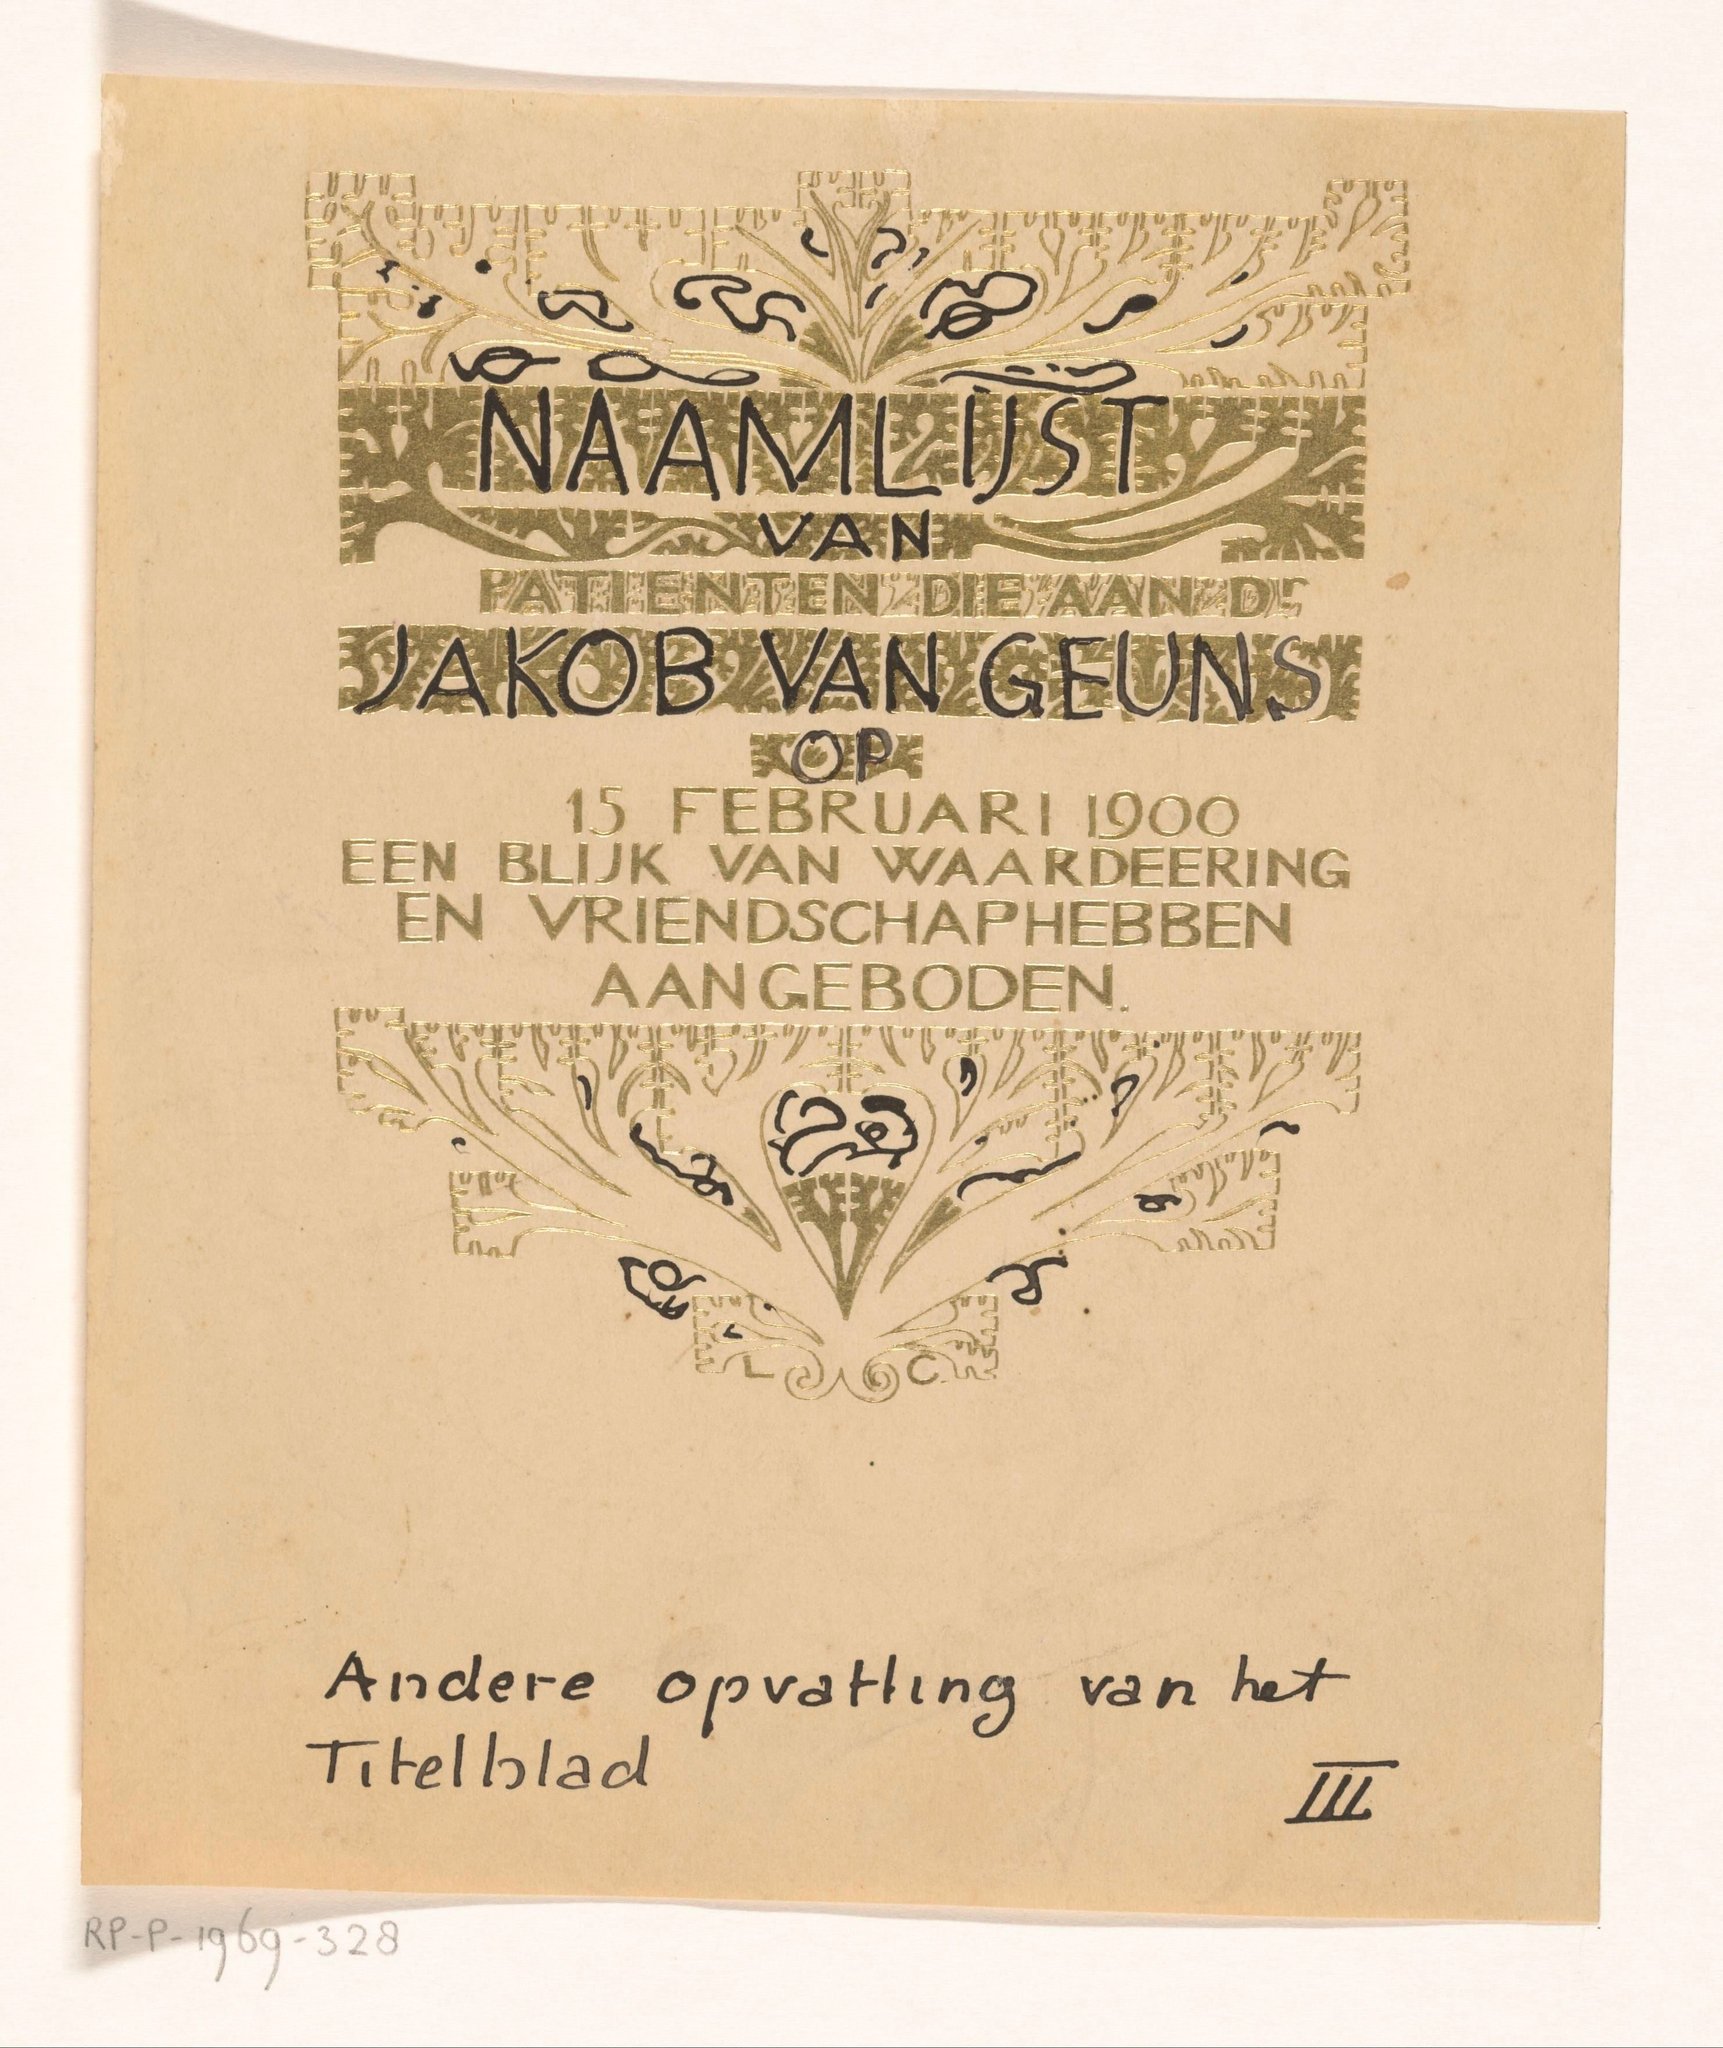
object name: gelegenheidsgrafiek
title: Huldeblijk aan Jacob van Geuns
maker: carel adolph lion cachet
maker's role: draughtsman, print maker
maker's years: 1864-1945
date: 1900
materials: ink, paper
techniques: pen, printing block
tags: ornament derived from plant forms - aa - stylized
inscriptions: collector's mark: Lugt 2228, annotation: ‘Andere opvatting van het Titelblad III’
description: Gestileerde plantmotieven rond de tekst 'Naamlijst van patienten die aan Dr. Jakob van Geuns op 15 februari 1900 een blijk van waardeering en vriendschap hebben aangeboden.'